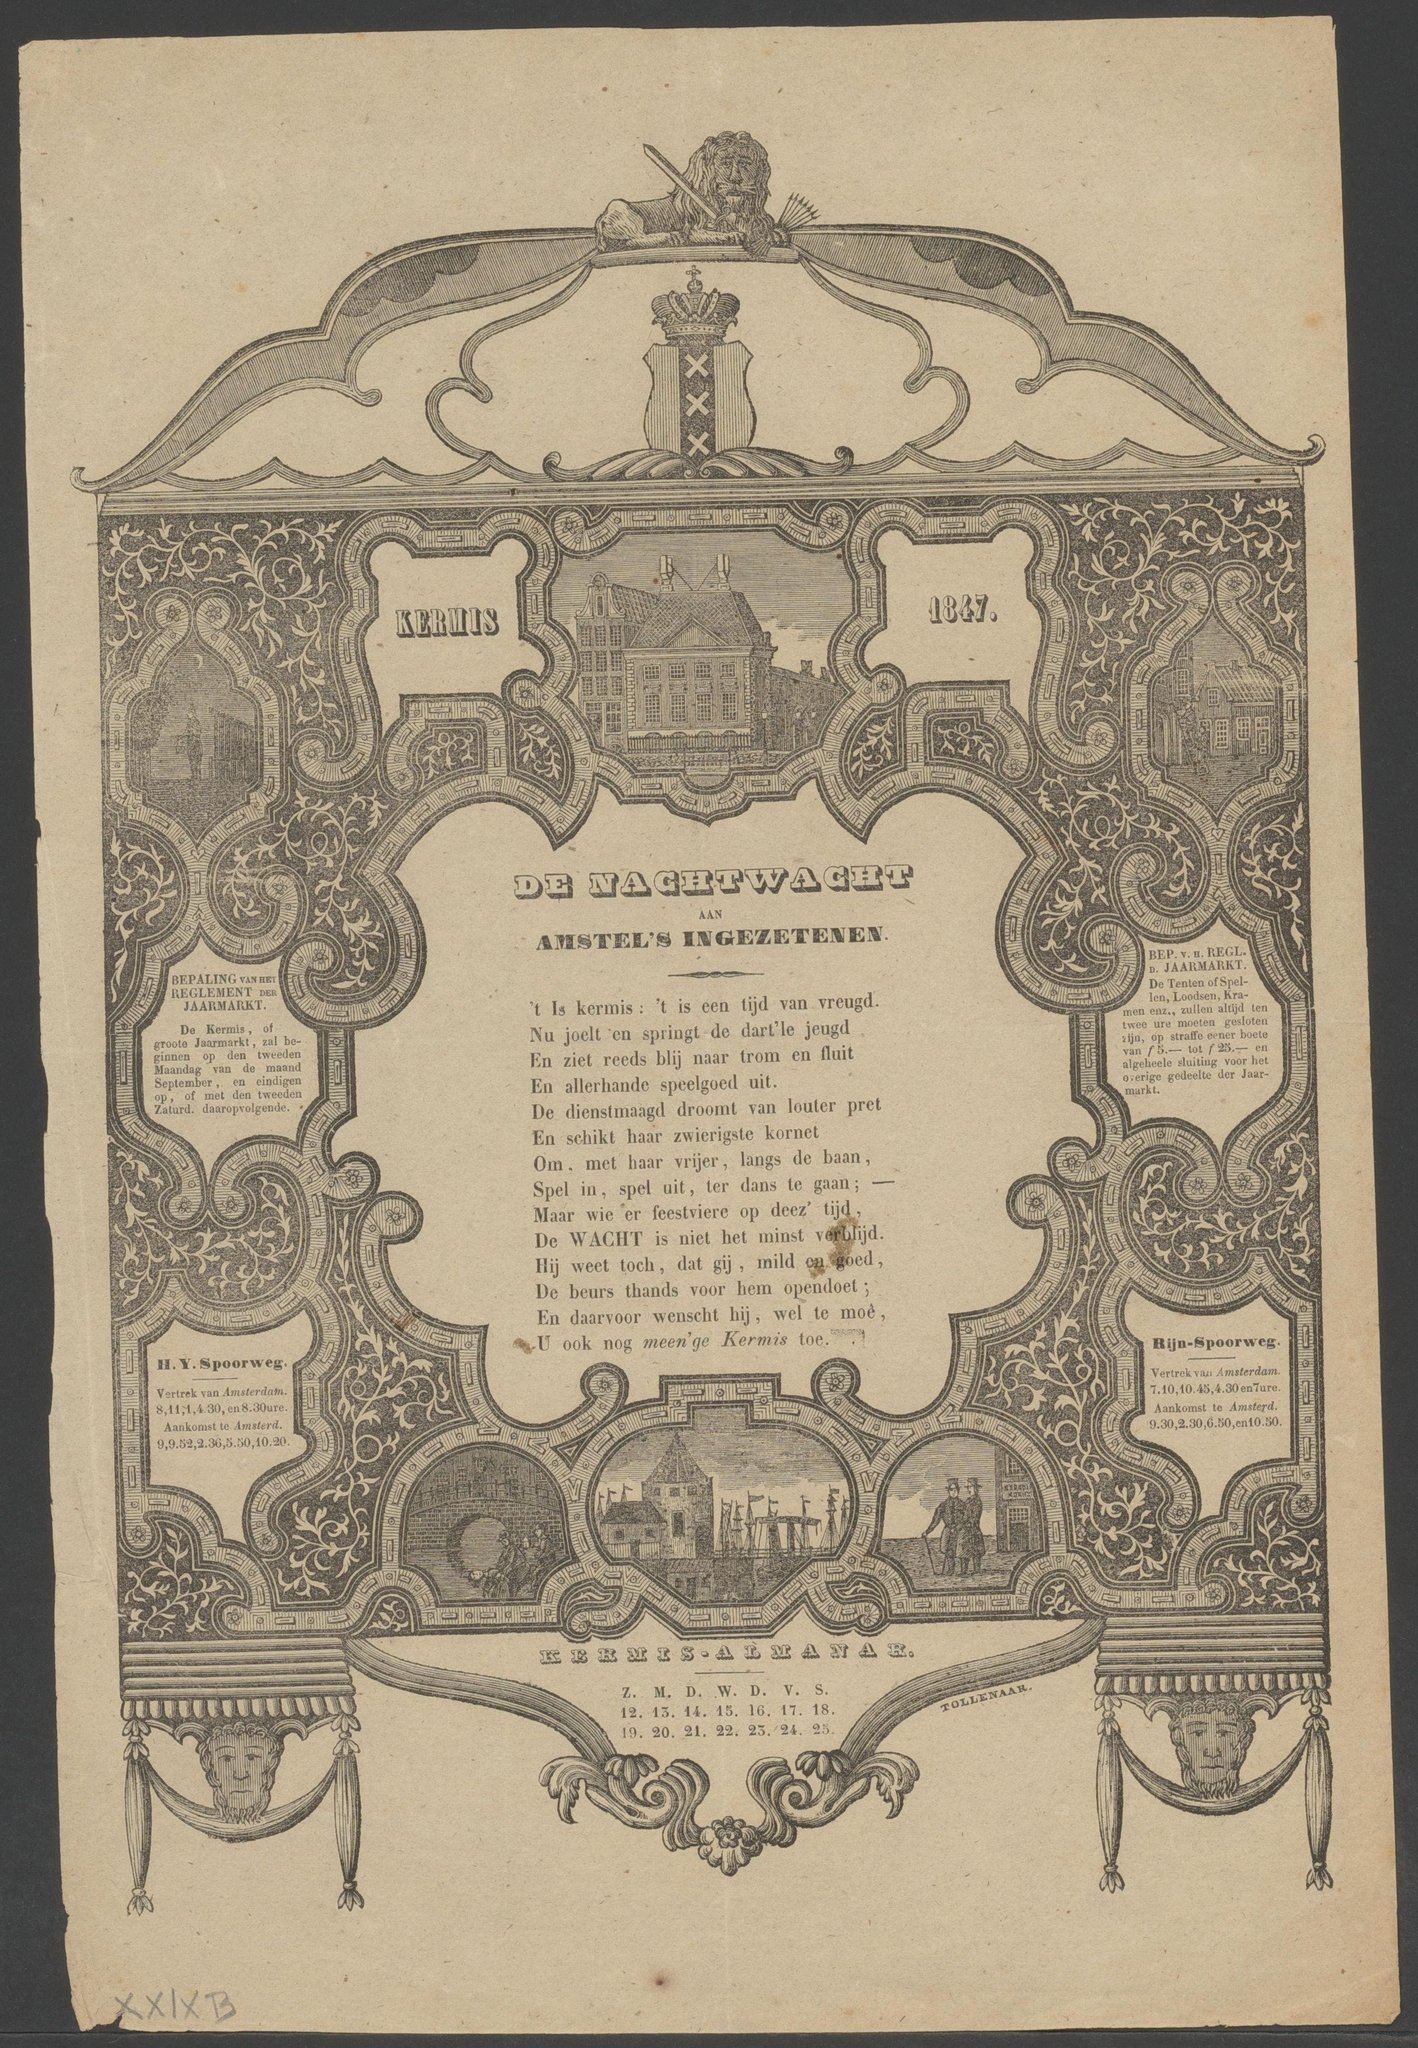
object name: print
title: Kermisprent van de Amsterdamse nachtwacht voor het jaar 1847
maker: dirk wijbrand tollenaar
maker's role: print maker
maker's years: 1808-1858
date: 1847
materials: paper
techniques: letterpress printing, engraving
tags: night patrol, amsterdam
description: Kermisprent van de Amsterdamse nachtwacht (ratelwacht), september 1847. Randwerk met zes kleine cartouches met afbeeldingen van de nachtwacht en gebouwen in Amsterdam. Ook met vier cartouches met tekst. Centraal een vers, onderaan de kermis-almanak (kalender). Onderwerpsrubrieken binnen de Atlas Zeden en Gewoonten: Zeden en gewoonten in engeren zin, Volksleven, Volksbladen, Nieuwjaars- en Kerstwenschen, Amsterdam.